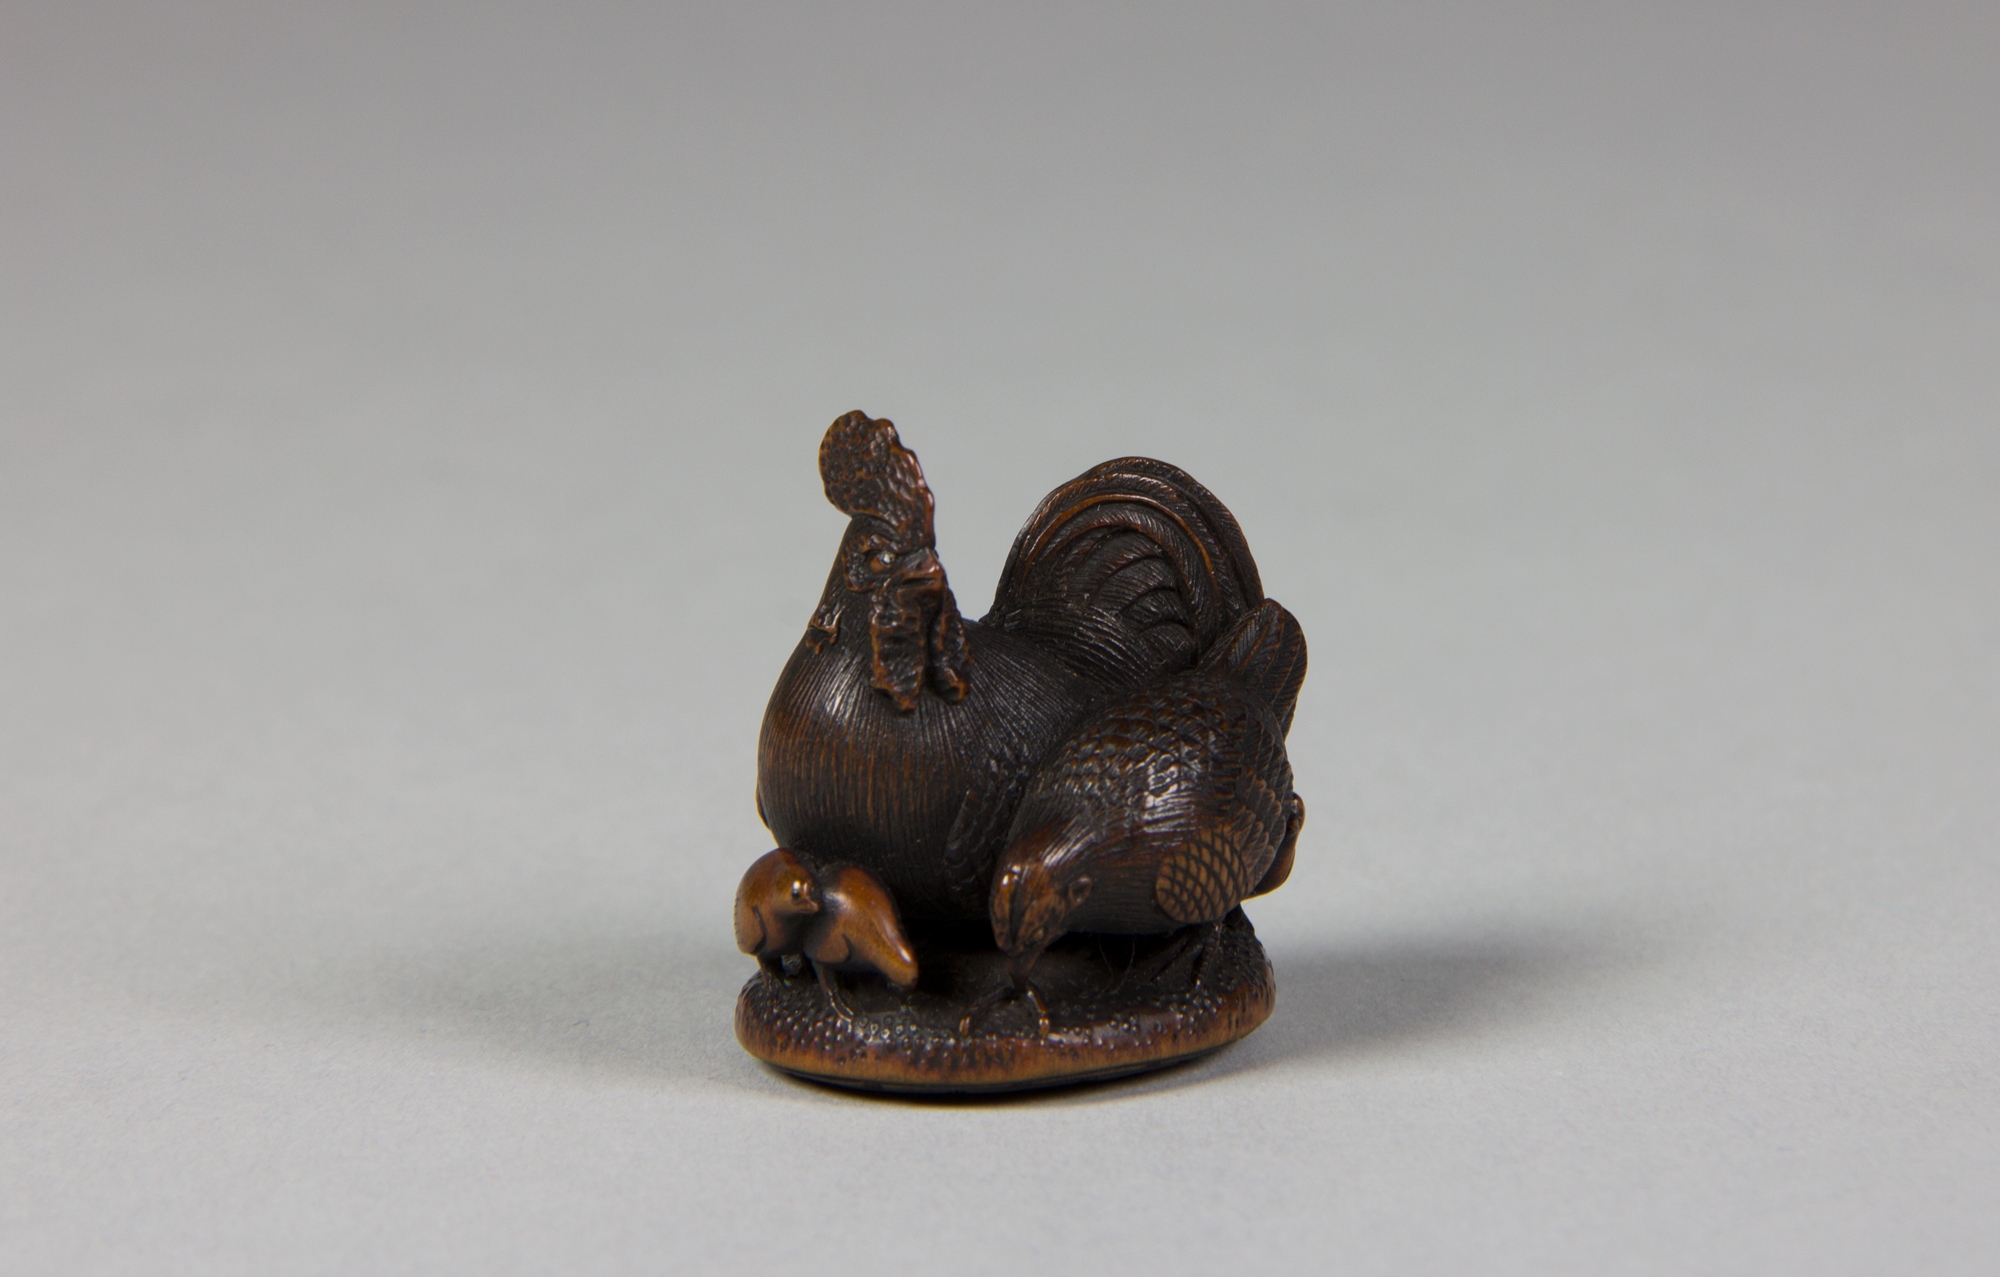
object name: netsuke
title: Netsuke of Chickens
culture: japanese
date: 1801-1900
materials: wood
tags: chickens